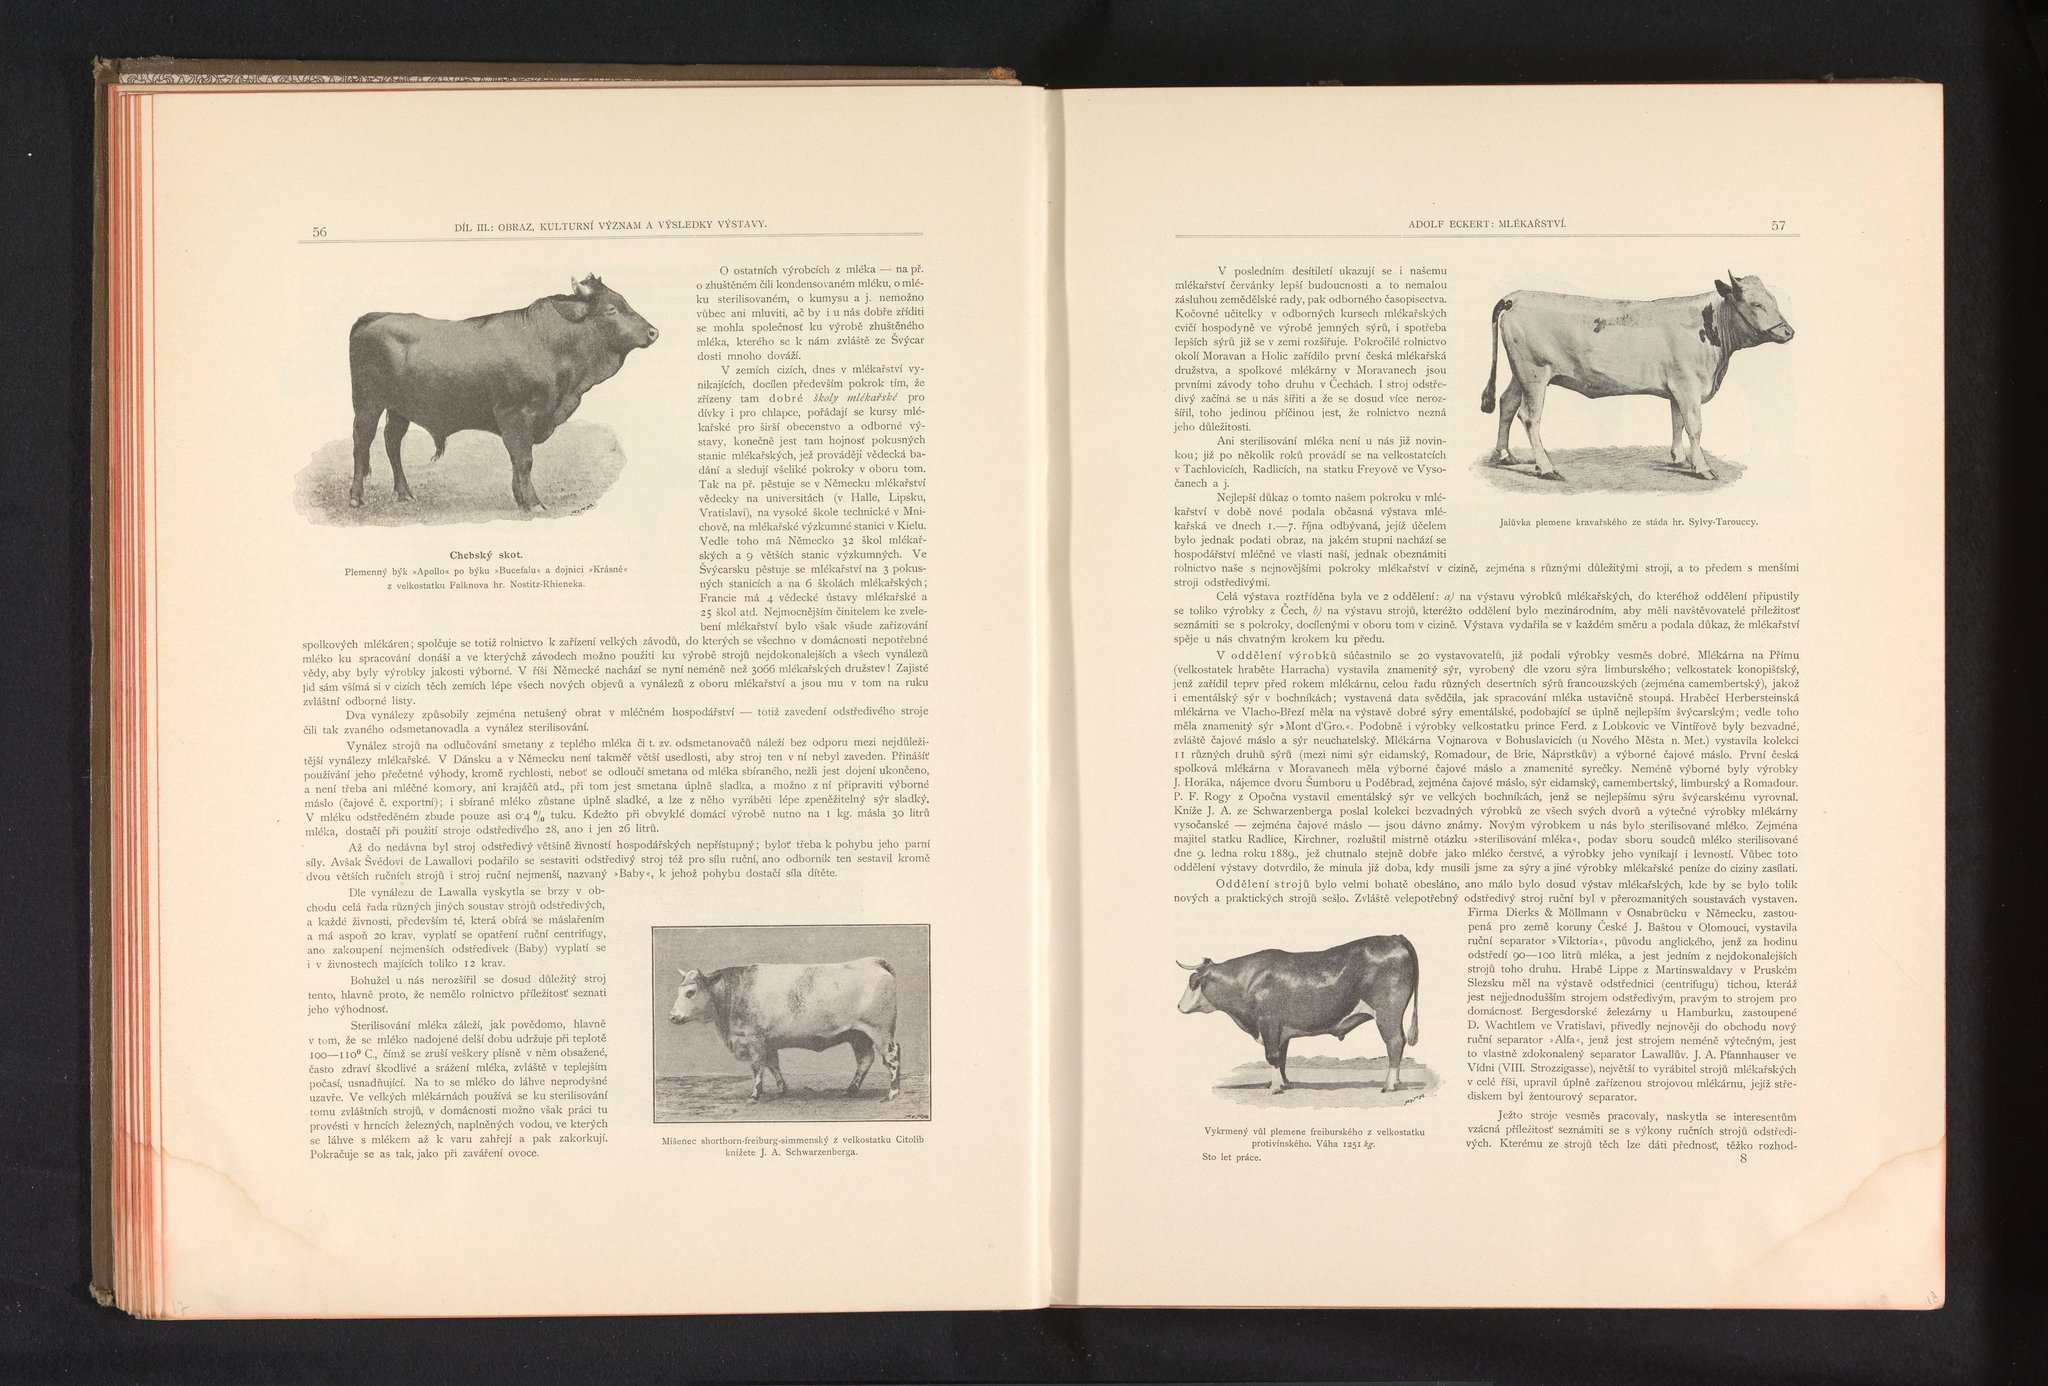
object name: photomechanical print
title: Twee stieren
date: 1891-1895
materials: paper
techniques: autotype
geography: prague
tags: bull